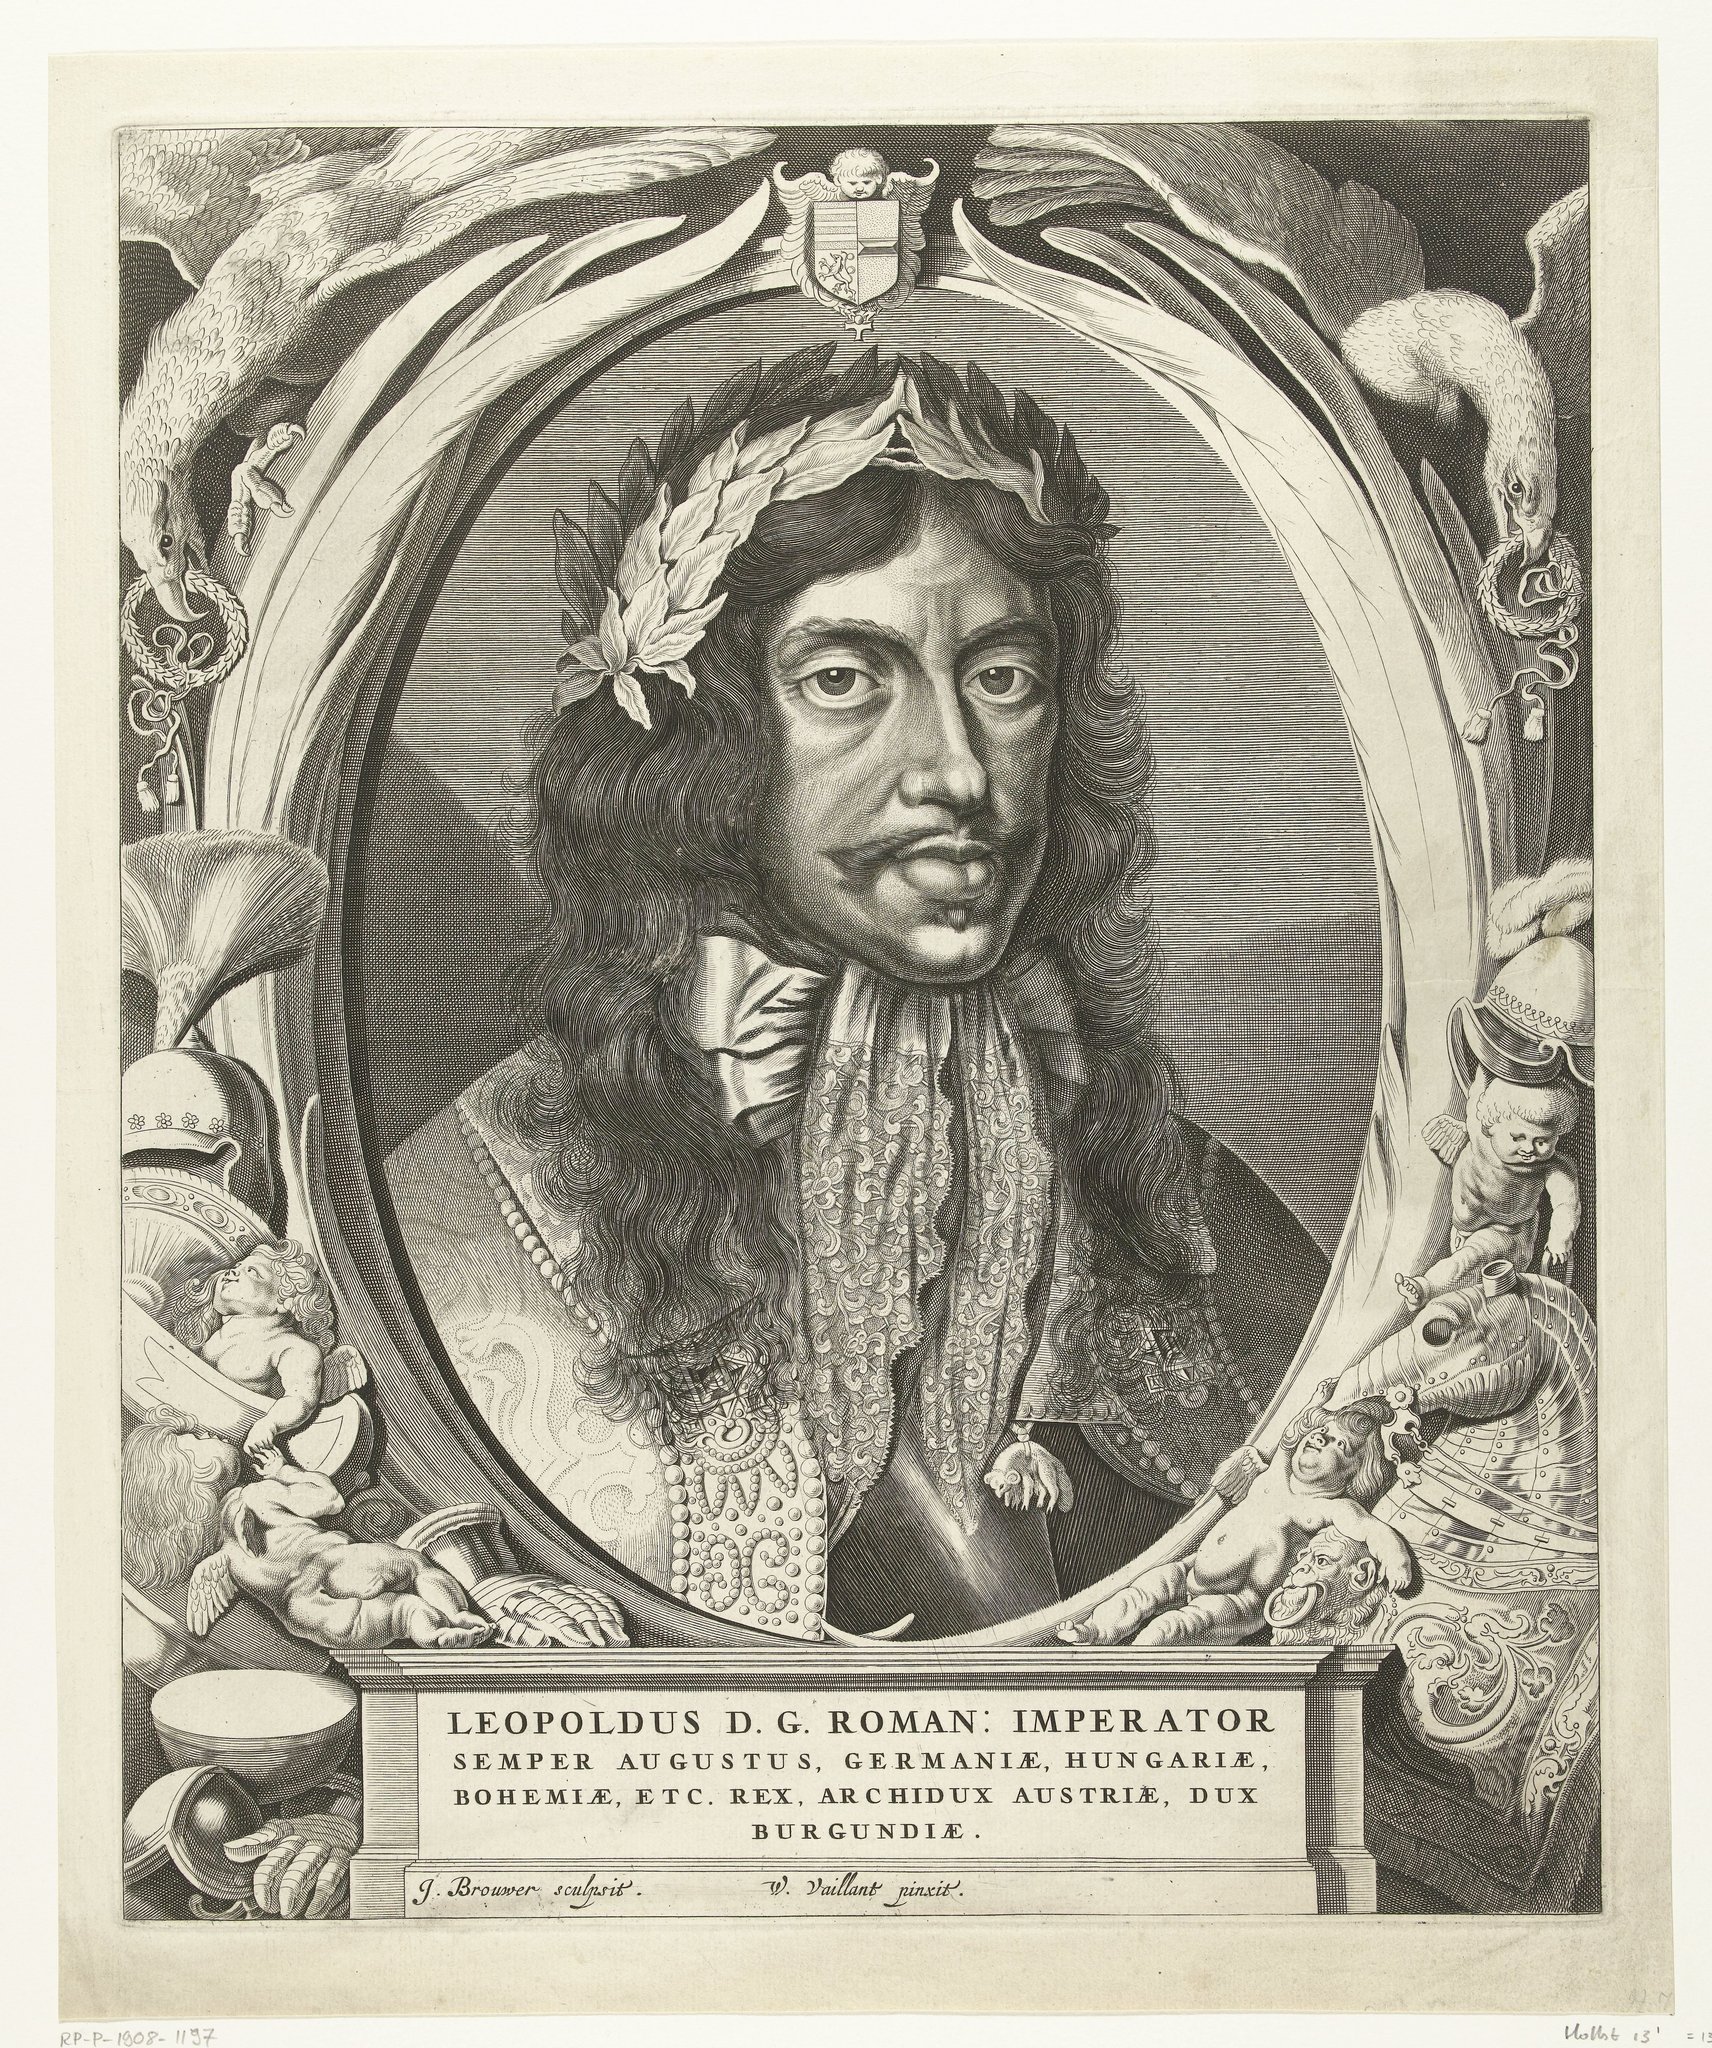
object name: print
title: Portret van keizer Leopold I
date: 1658-1688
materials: paper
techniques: engraving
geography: amsterdam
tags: vienna, leopold i (keizer van duitsland), knighthood order of the golden fleece - insignia of a knighthood order, e.g.: badge, chain (with name of order)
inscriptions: collector's mark: Lugt 2228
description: Portret van de keizer Leopold I met lauwerkrans in het haar. Leopold draagt de ketting van het Gulden Vlies om zijn hals. Met een ornamentele lijst uit putti, adelaars en onderdelen van een wapenrusting. Onder het portret zijn naam en titels.